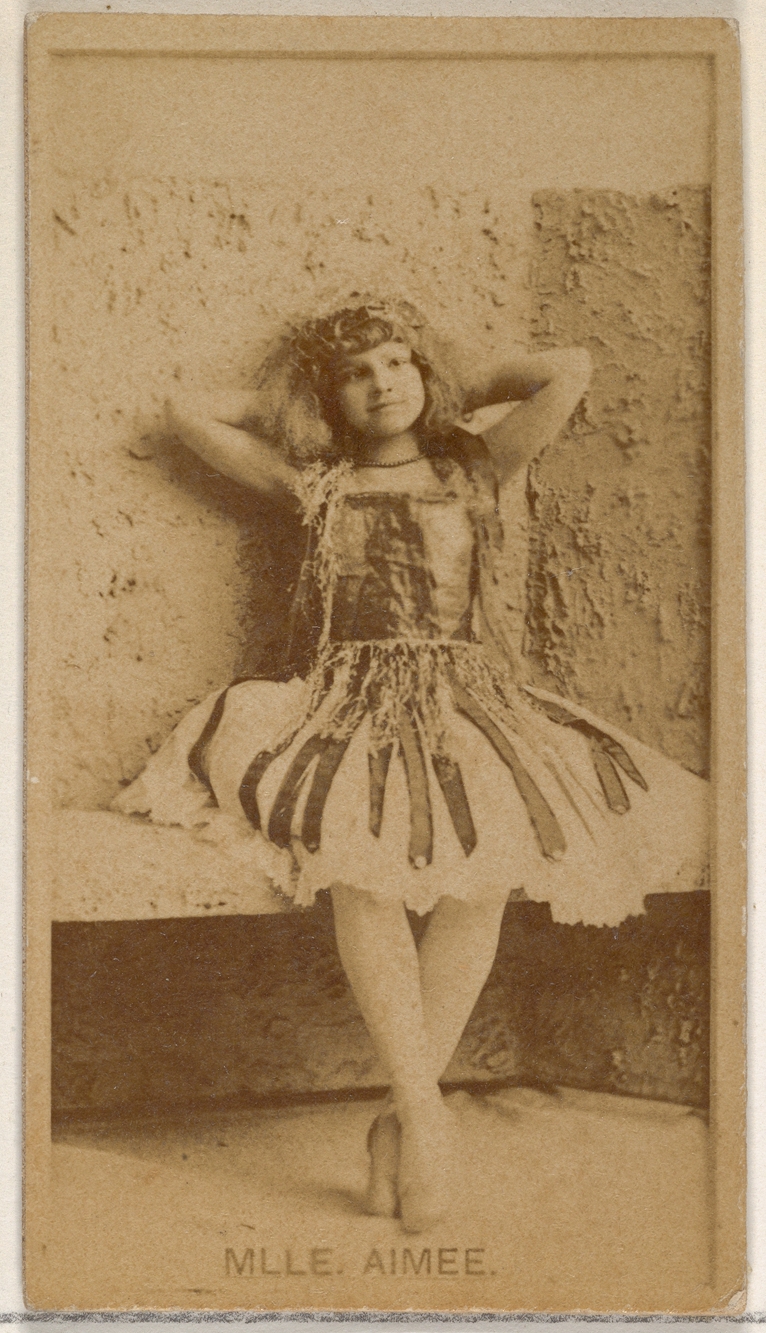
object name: photograph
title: Mlle. Aimee, from the Actors and Actresses series (N45, Type 8) for Virginia Brights Cigarettes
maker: allen & ginter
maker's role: publisher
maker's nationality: american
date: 1888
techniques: albumen silver print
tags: portraits,women,actresses